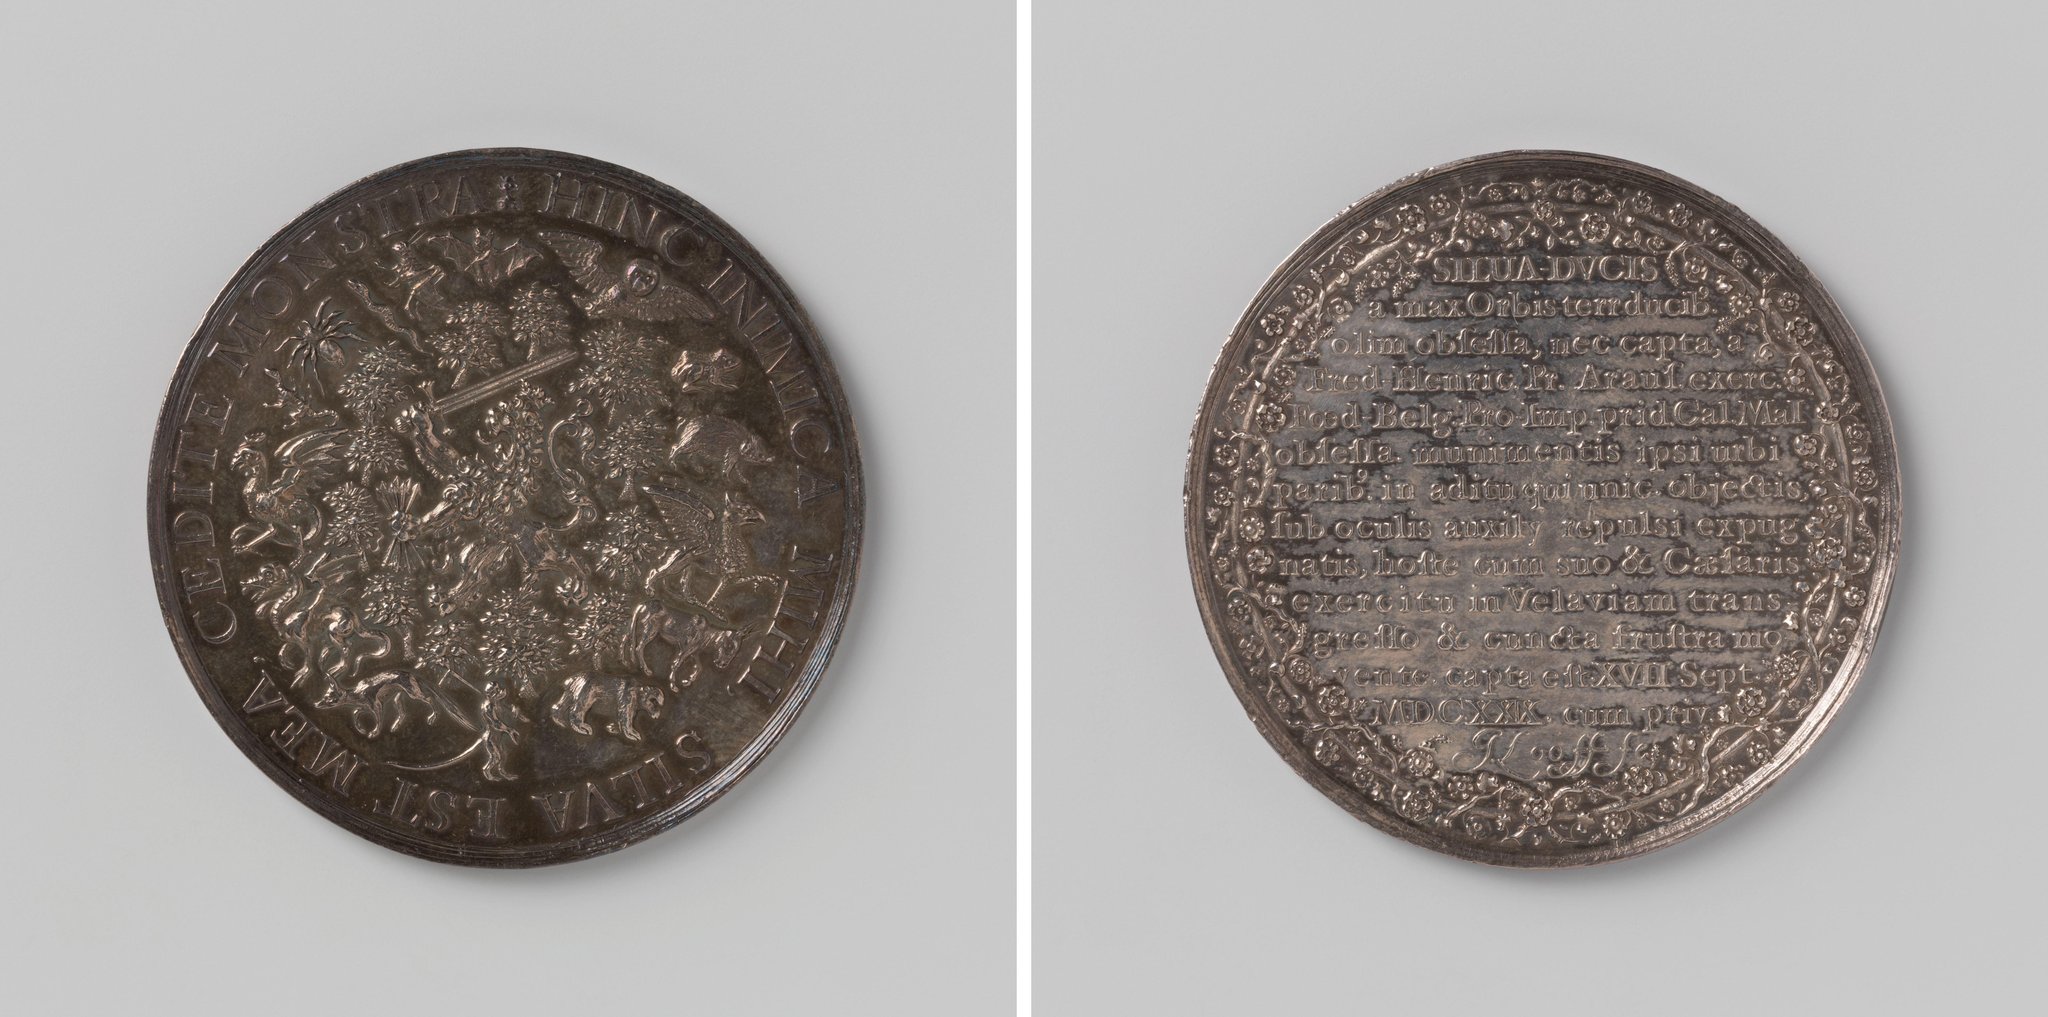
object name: history medal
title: Inname van 's Hertogenbosch door Frederik Hendrik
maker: johannes looff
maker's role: die cutter, draughtsman, print maker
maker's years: -1651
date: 1638-1639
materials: silver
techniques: striking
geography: middelburg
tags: frederick henry (prince of orange), den bosch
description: Zilveren penning. Voorzijde: gekroonde leeuw met zwaard verdrijft verschillende dieren uit bos, binnen omschrift. Keerzijde: opschrift binnen zegekrans